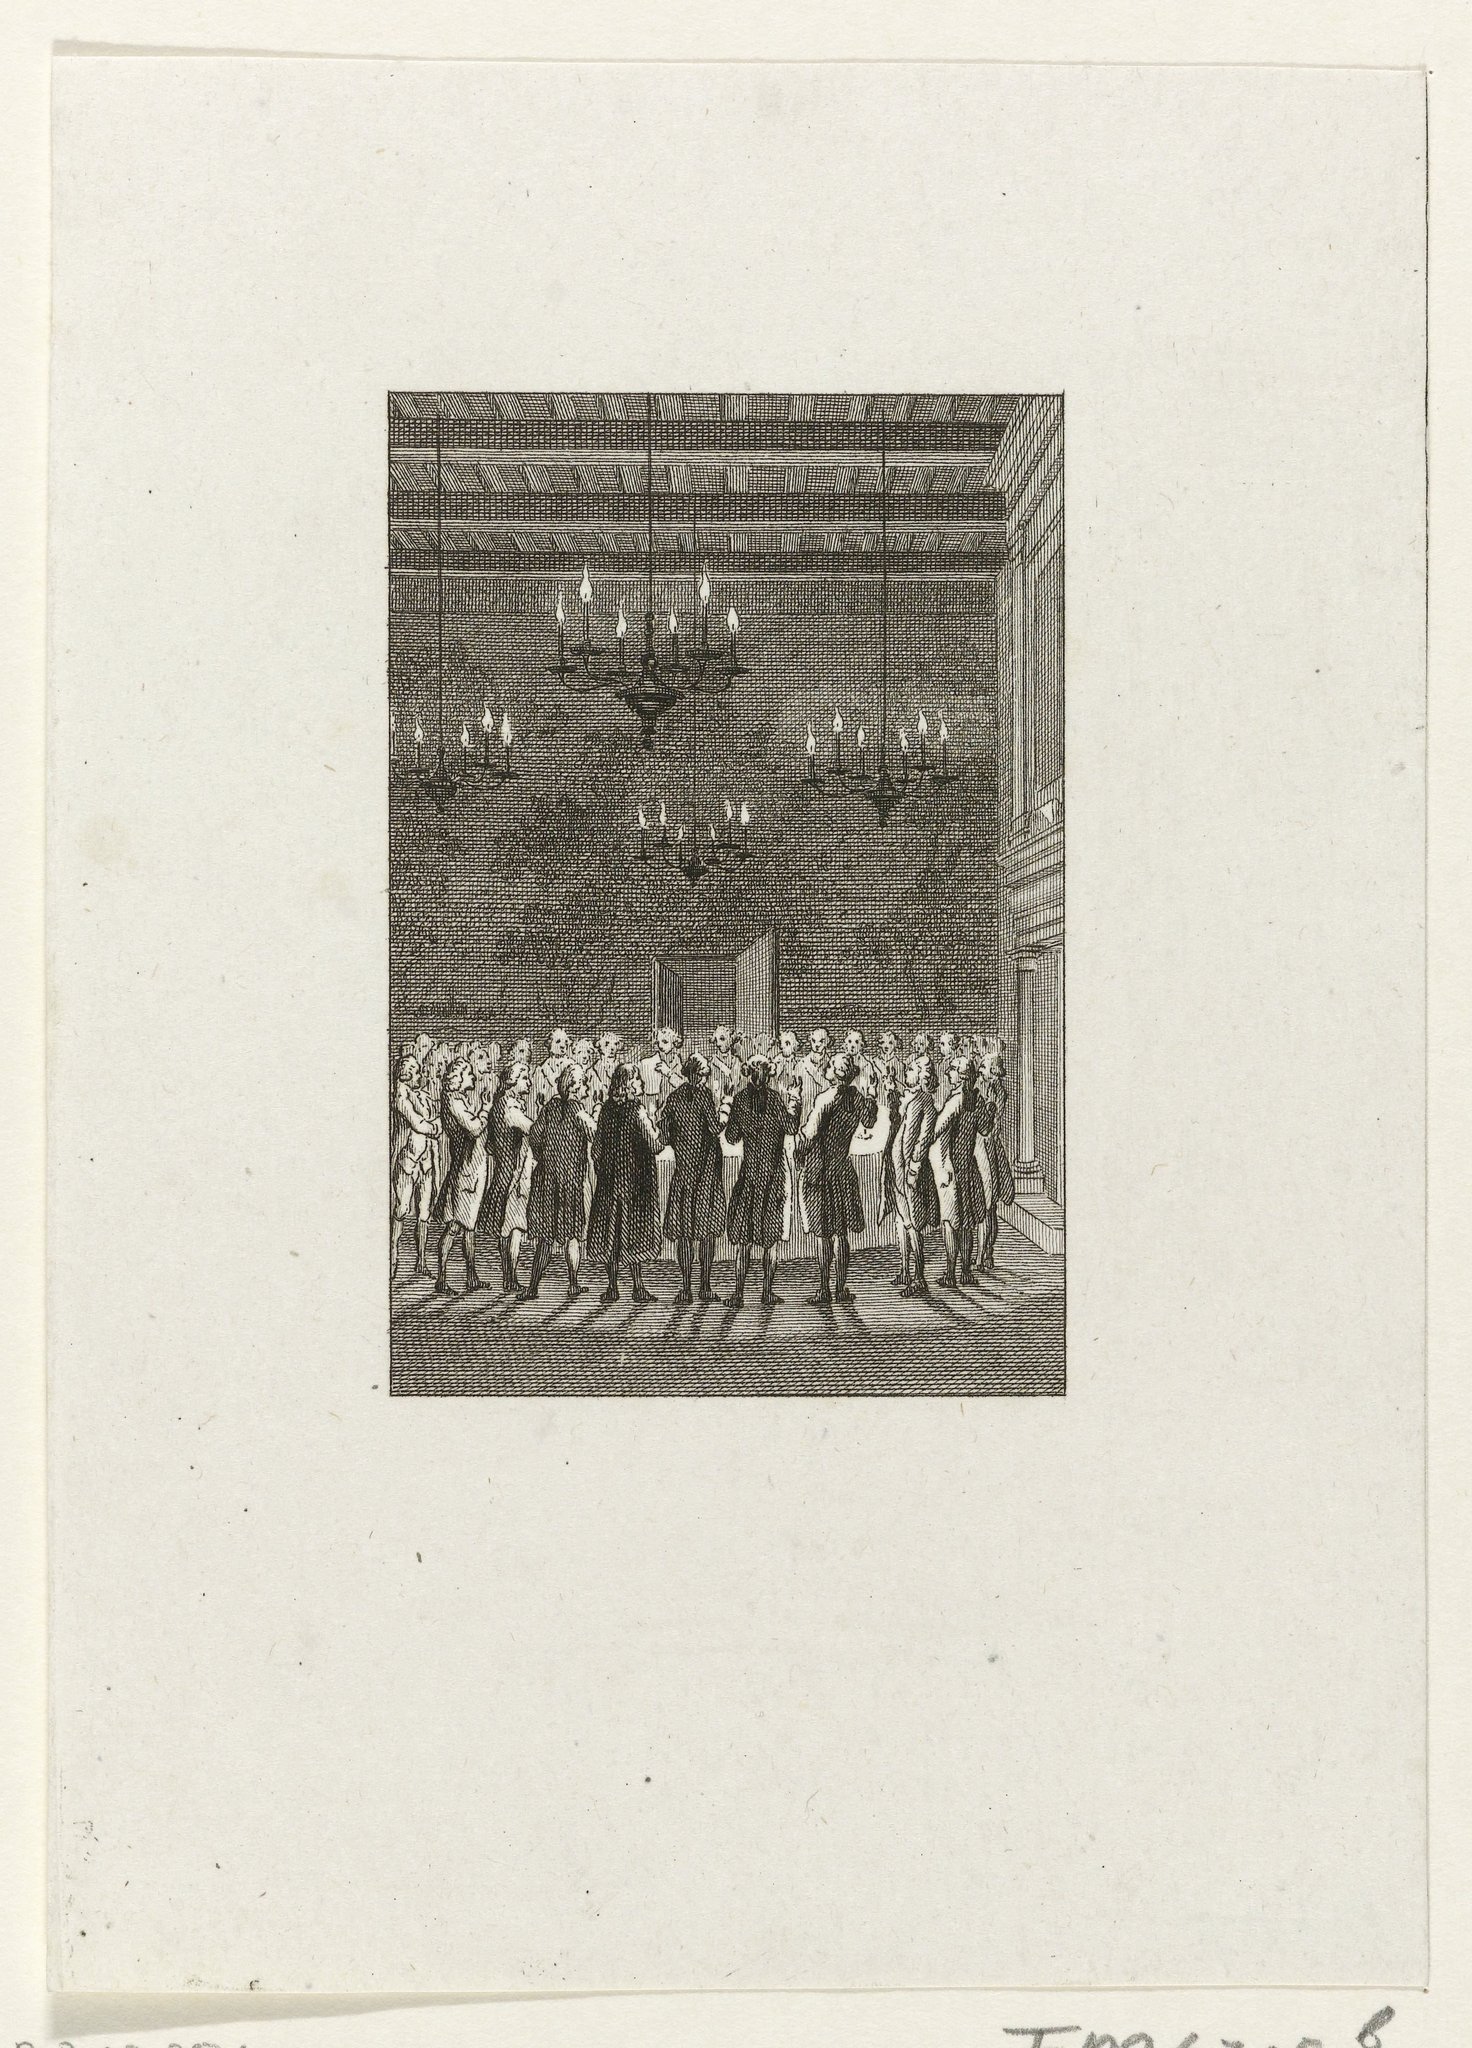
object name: print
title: Vroedschap legt de eed af te Utrecht, 1786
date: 1786-1795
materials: paper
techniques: engraving, etching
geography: northern netherlands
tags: city council, swearing an oath (with two fingers raised), patriots (1780-1795)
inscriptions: collector's mark: Lugt 2228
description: Verkleinde kopie naar de prent van Bendorp naar Bulthuis, FMH 4702. Gebruikt als illustratie in: J. Fokke, Geschiedenissen der Vereenigde Nederlanden voor de vaderlandsche jeugd, Johannes Allart, Amsterdam 1783-1795, 25 delen, dl. 16, pl. 3.